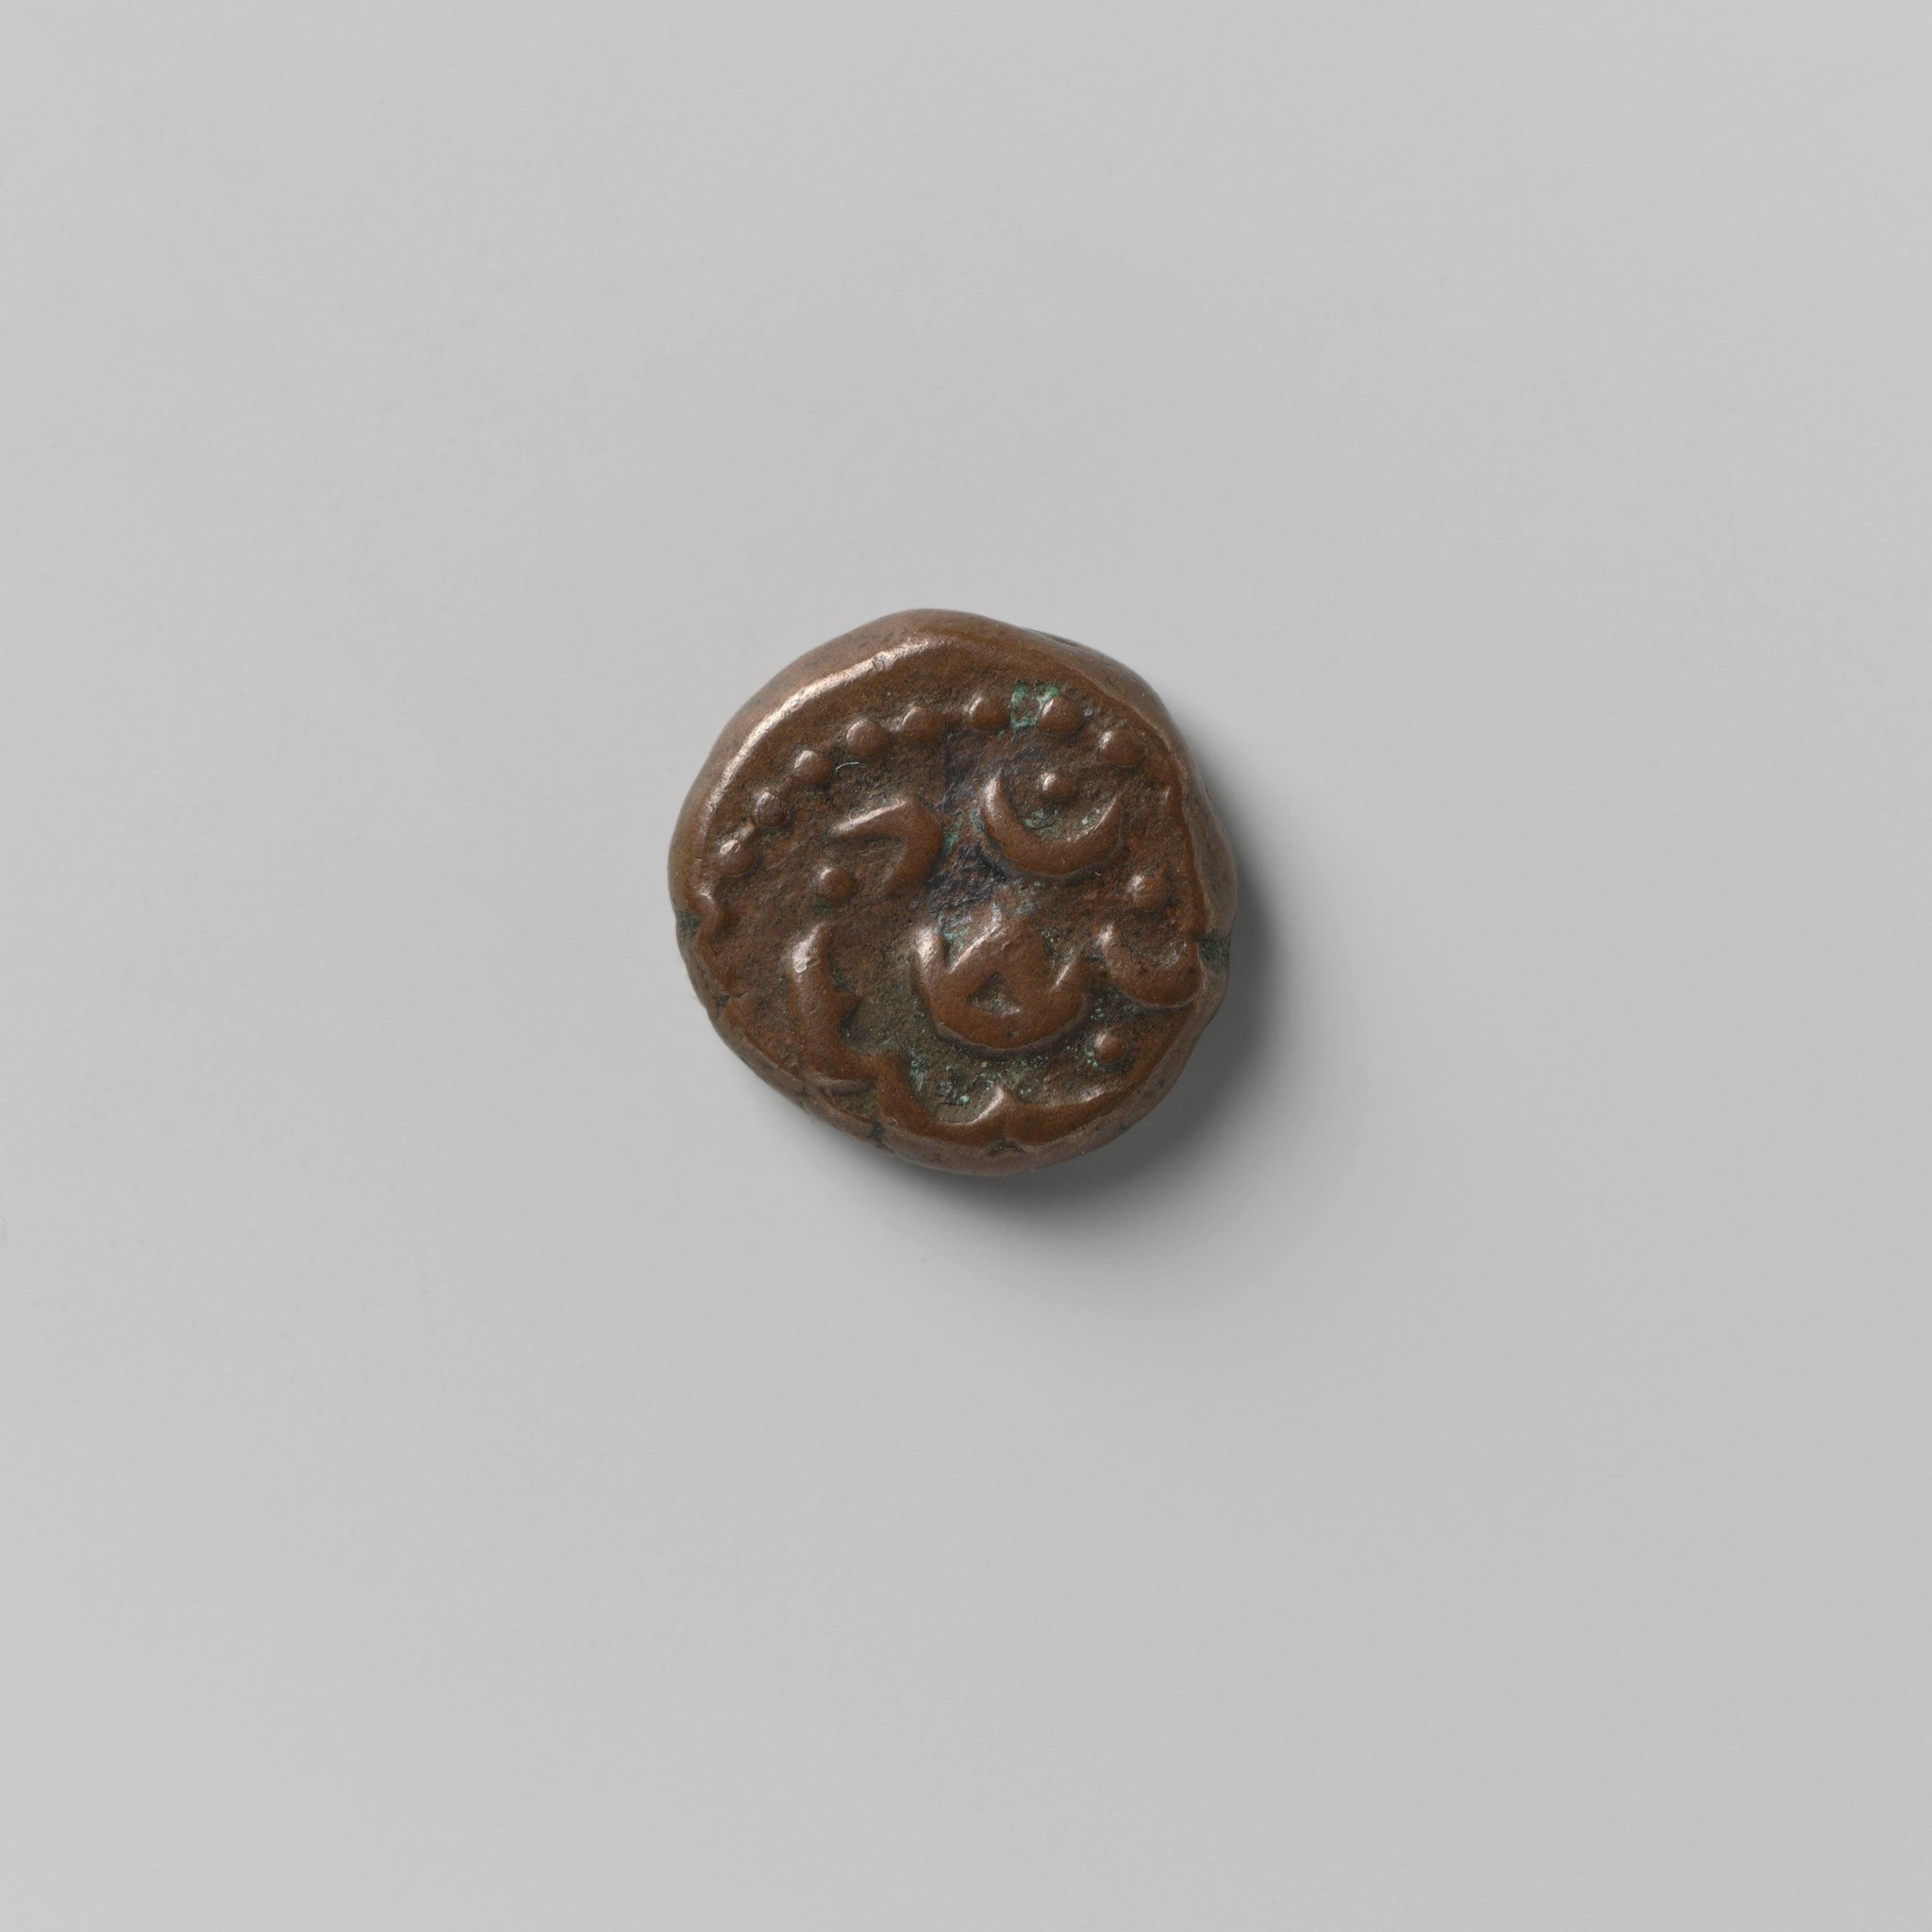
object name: coin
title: VOC, Paliakate, Voor-Indië, kas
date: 1650-1700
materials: copper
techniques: striking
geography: paliacatta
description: Koperen munt. Voorzijde: monogram van de VOC, waarboven letter P. Keerzijde: drieregelig opschrift in Arabische lettertekens. Gladde rand.